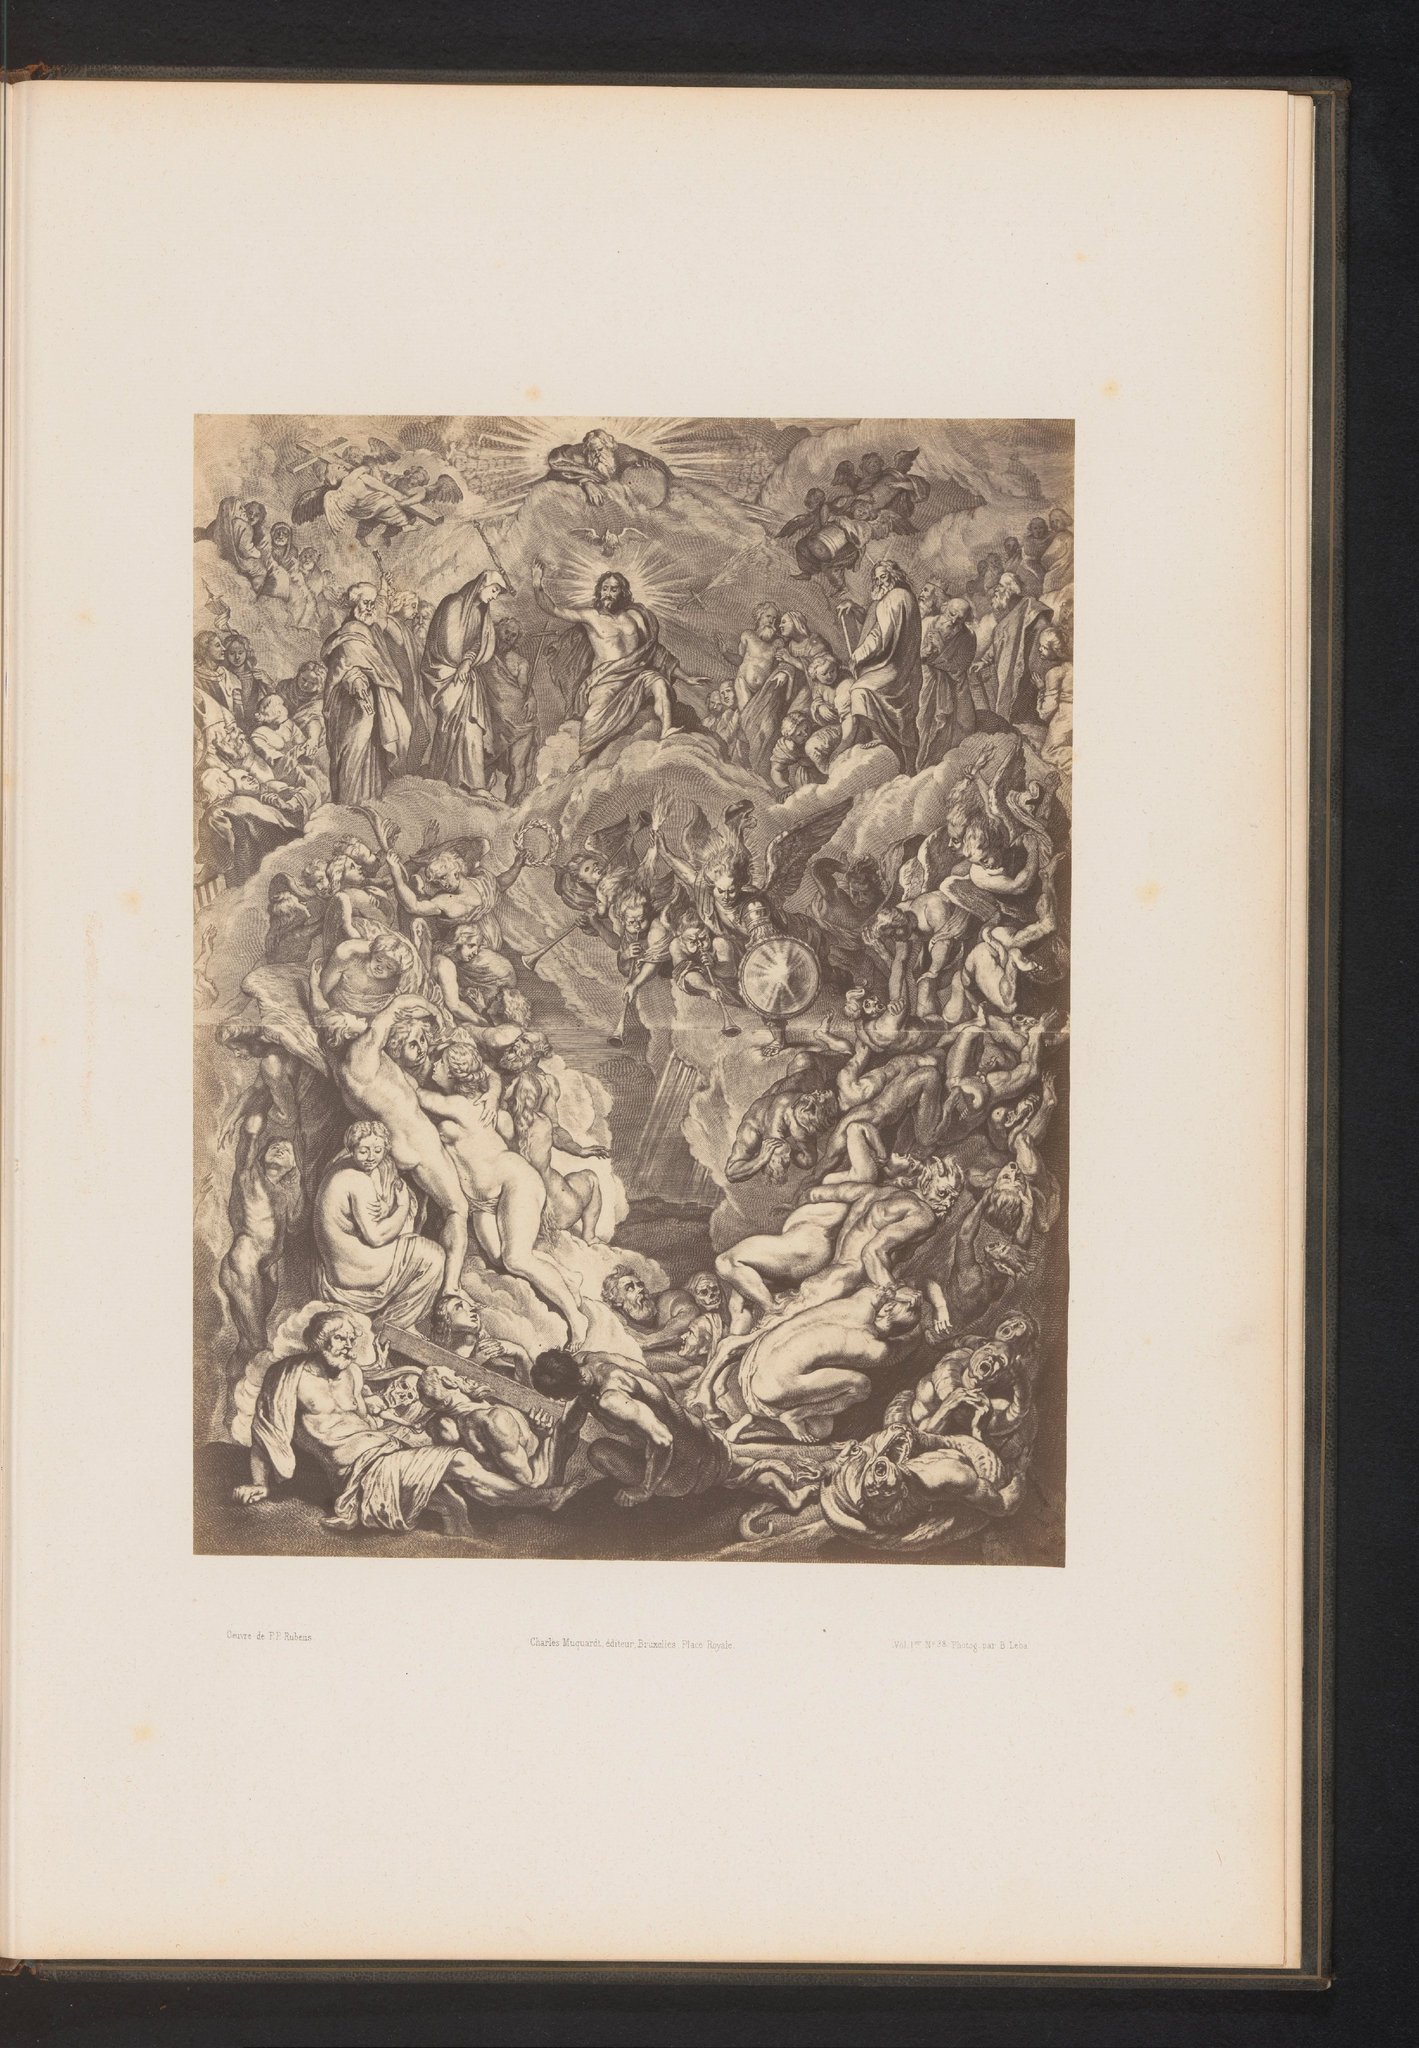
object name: photograph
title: Fotoreproductie van een gravure van Het laatste oordeel door Cornelis Visscher II, naar het schilderij door Peter Paul Rubens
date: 1853-1858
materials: photographic support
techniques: albumen print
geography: brussels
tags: comprehensive representation of last judgement: christ (with sword and lily), often surrounded by elders and sometimes accompanied by mary and john the baptist, appears in the sky with trumpeting angels (and sometimes angels holding the instruments of the passion); after the resurrection of the dead the blessed are led to heaven by angels, and the damned are dragged into hell by devils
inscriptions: number: ‘Vol. 1er. No 38.’